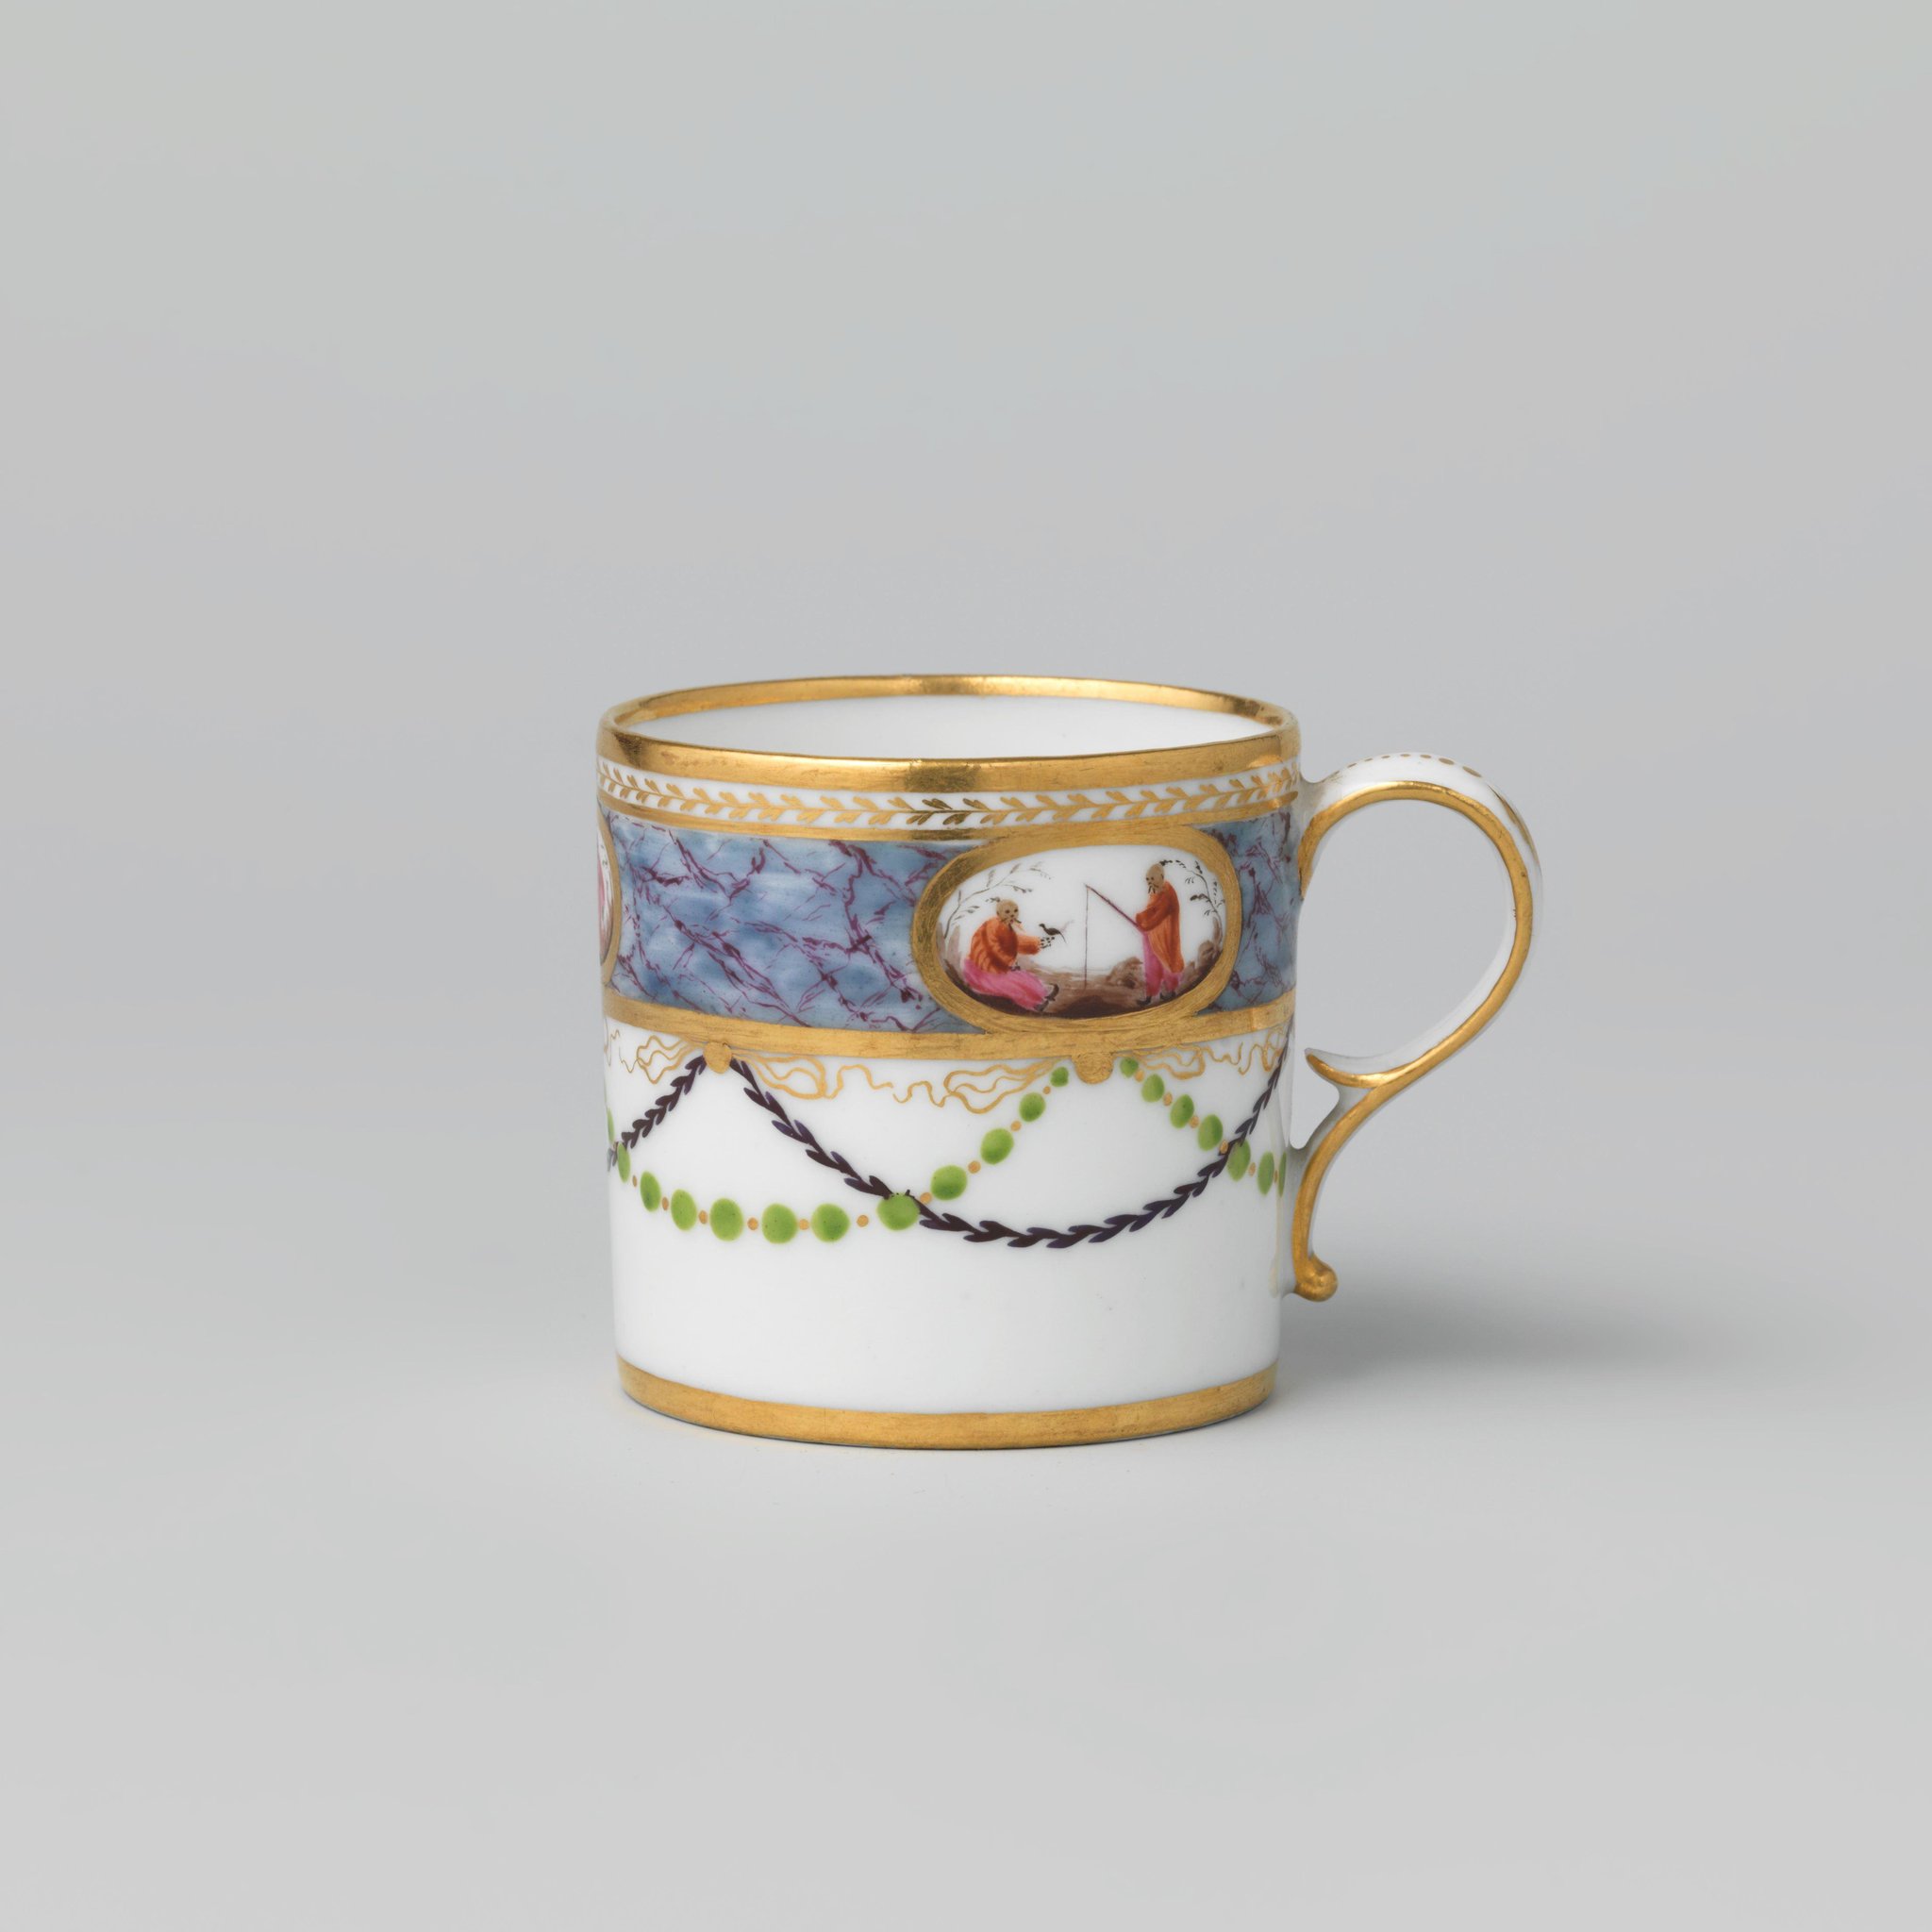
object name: cup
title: Cup with a marbled, matte purple border with Chinese scenes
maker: Anonymous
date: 1790-1800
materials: glaze, gold, paint, porcelain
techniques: firing, forming, gilding, turning, vitrification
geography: france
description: Kop van porselein met een cilindrisch lichaam en C-vormig oor, beschilderd op het glazuur in rood, roze, groen, bruin, zwart en goud. Op de buitenwand een gemarmerde matpaarse band met Chinese voorstellingen (Chinoiserie) in gouden medaillons. Hieronder een guirlande en een slinger. Gouden banden op de rand en boven de voet. Op het oor gouden stippen.